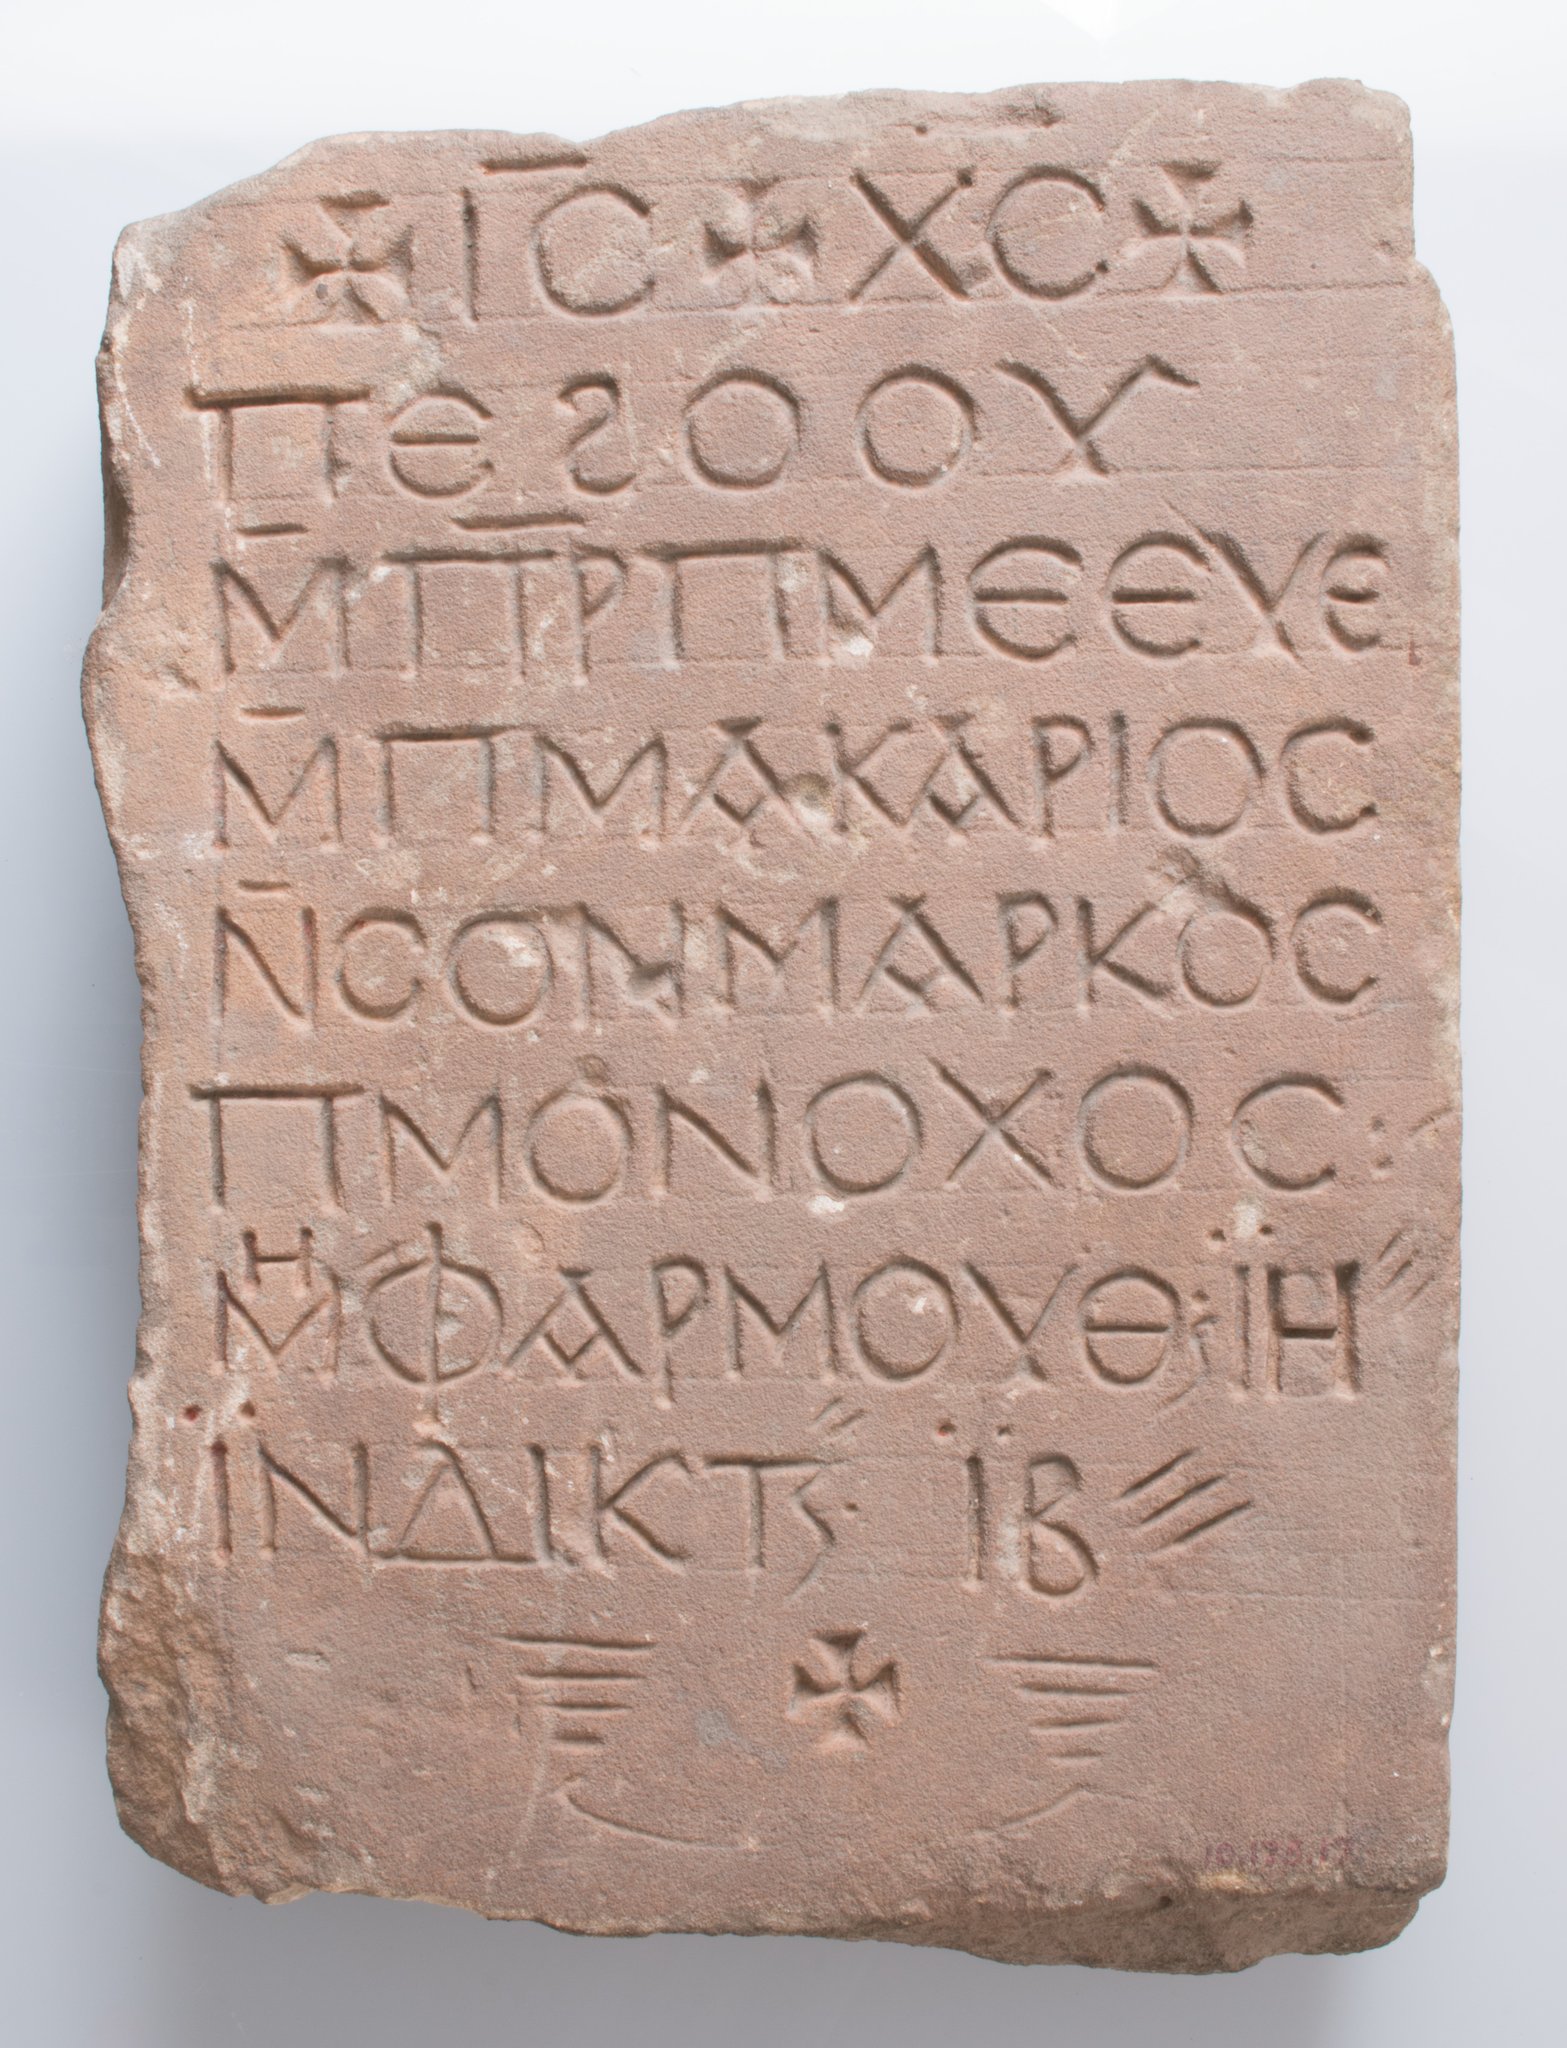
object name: stele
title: Inscribed Stele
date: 201-1200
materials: stone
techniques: incising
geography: egypt